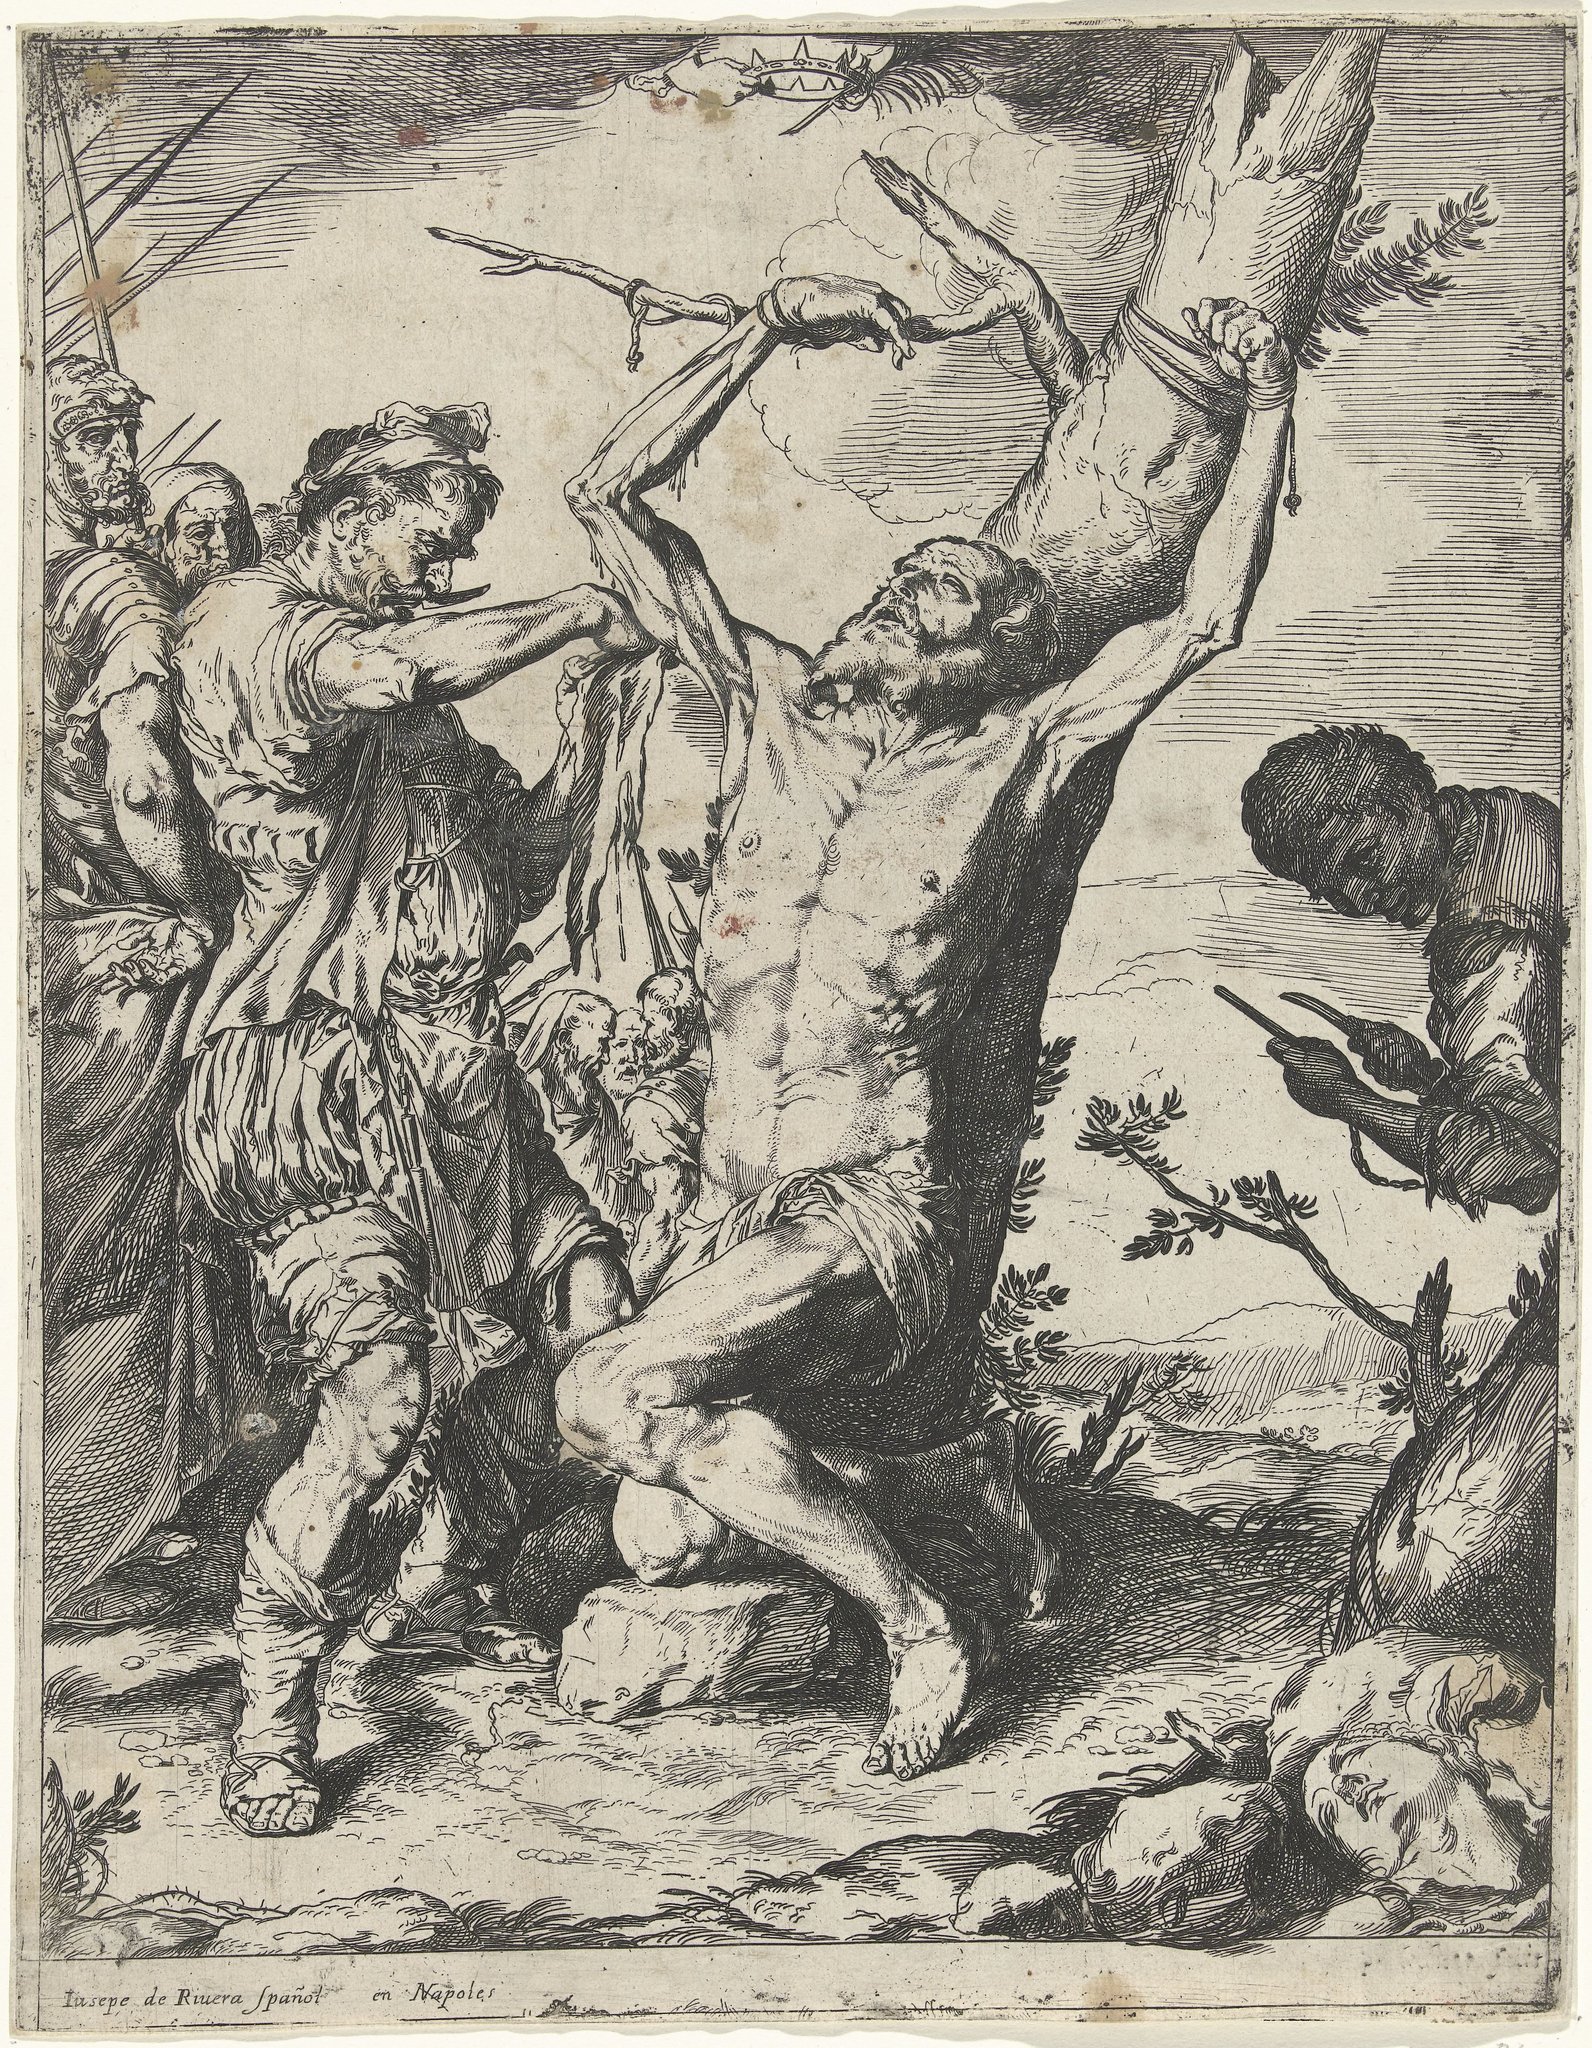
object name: print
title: Martelaarschap van de Heilige Bartholomeus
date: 1624-1700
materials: paper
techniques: etching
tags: bartholomew flayed alive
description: De heilige Batholomeus, vastgebonden aan een boom. Naast hem staat een man die de huid van zijn arm met een mes aan het villen is. Aan de hemel een hand die een kroon met palmtak vasthoudt boven de heilige.